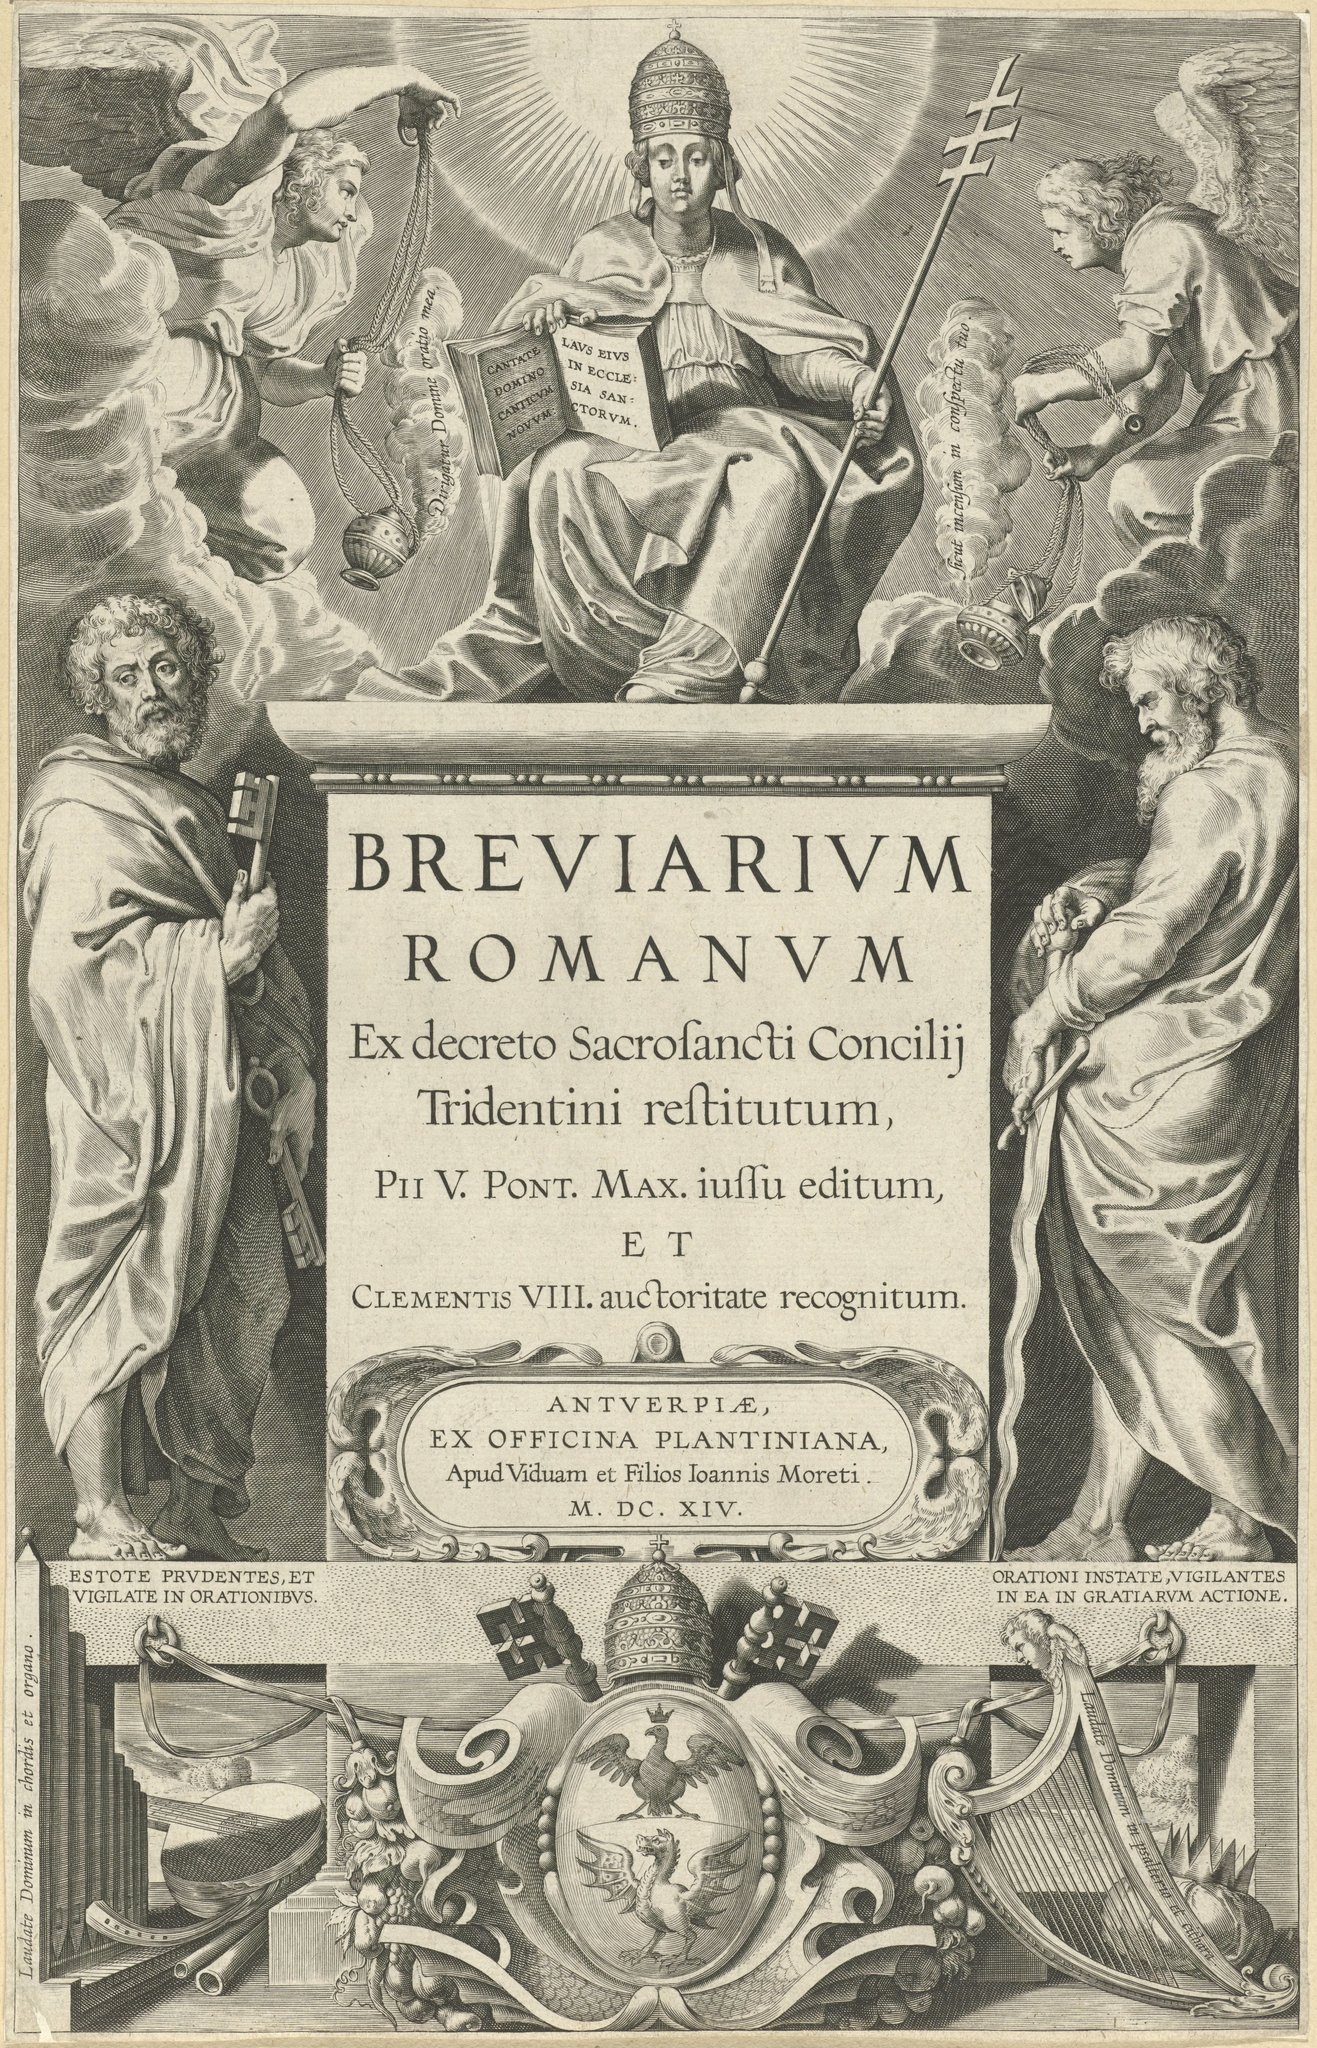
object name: print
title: Breviarium Romanum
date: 1614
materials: paper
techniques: engraving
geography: antwerp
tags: paulus v, triumph of the church (or religion), insignia of the pope, e.g. tiara, angels, the apostle peter, first bishop of rome; possible attributes: book, cock, (upturned) cross, (triple) crozier, fish, key, scroll, ship, tiara, armorial bearing, heraldry, the apostle paul of tarsus; possible attributes: book, scroll, sword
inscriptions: collector's mark: Lugt 240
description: Centraal de titel van het boek in een rechthoekig kader. De apostelen Petrus en Paulus aan weerszijden van het titelkader. Bovenaan de tronende personificatie van de Rooms-katholieke kerk. In haar handen de driedubbele bisschopsstaf en een Bijbel. Op haar hoofd een pauselijke tiara. Engelen staan rondom haar met wierook. Onderaan het wapenschild van Paulus V.